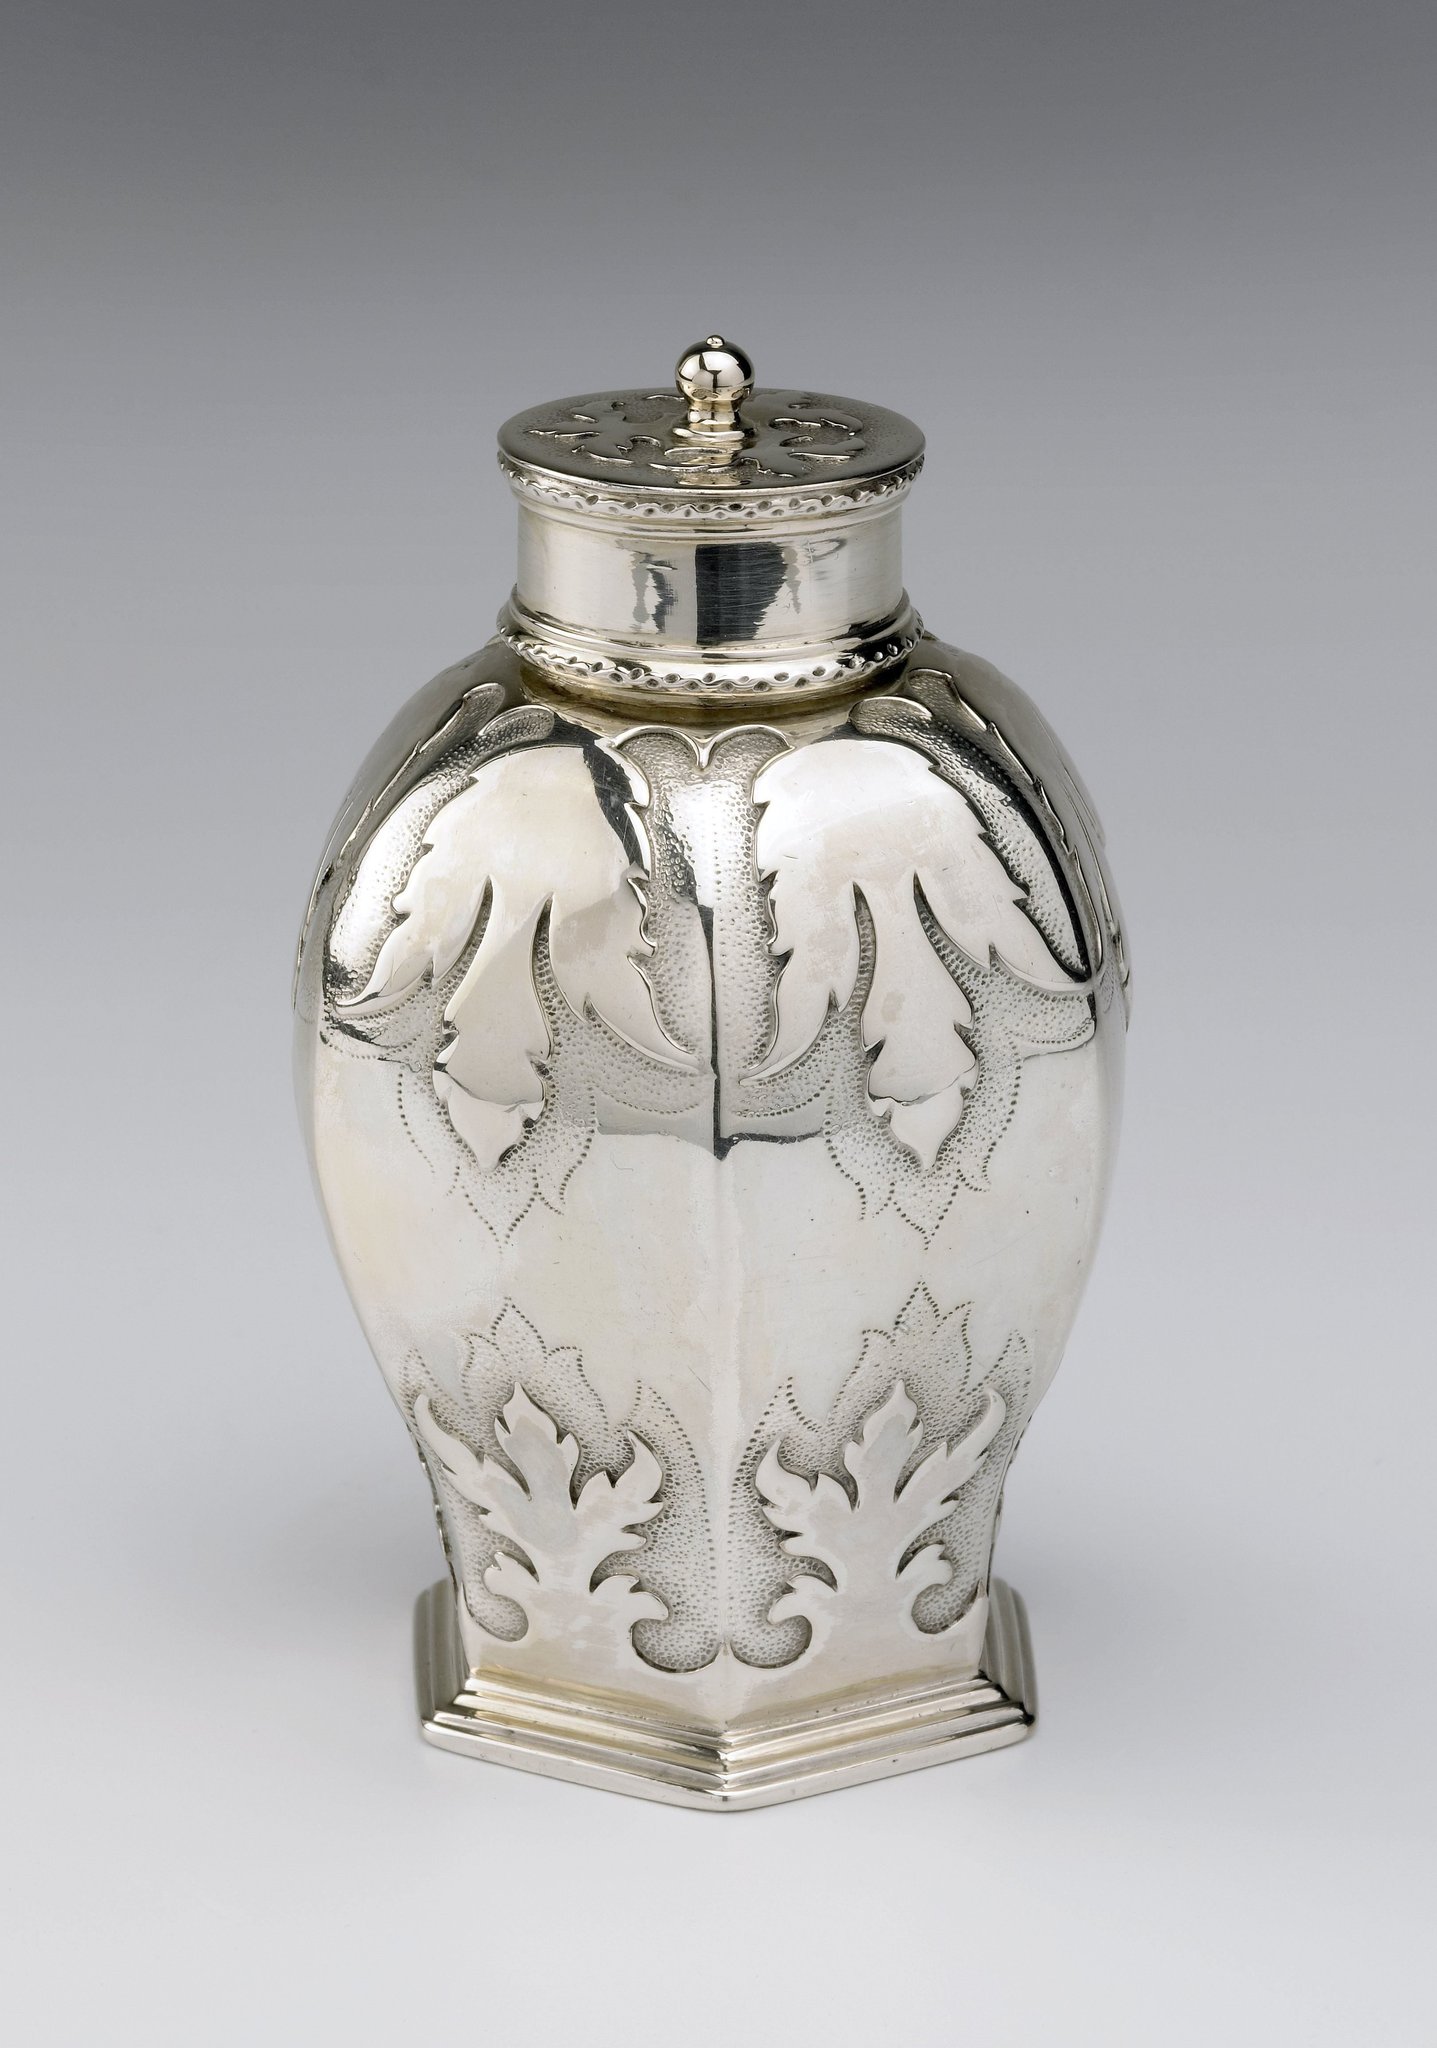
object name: tea caddy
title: Theebus met opgelegd acanthusblad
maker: jacques chevalier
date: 1695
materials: silver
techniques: casting, metalworking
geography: the hague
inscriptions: maker's mark, alloy mark, date letter: ‘W’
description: Tea caddy. Silver. The Hague, 1695 maker's mark a lamb in an oval. Lent by the Rijksmuseum Foundation.